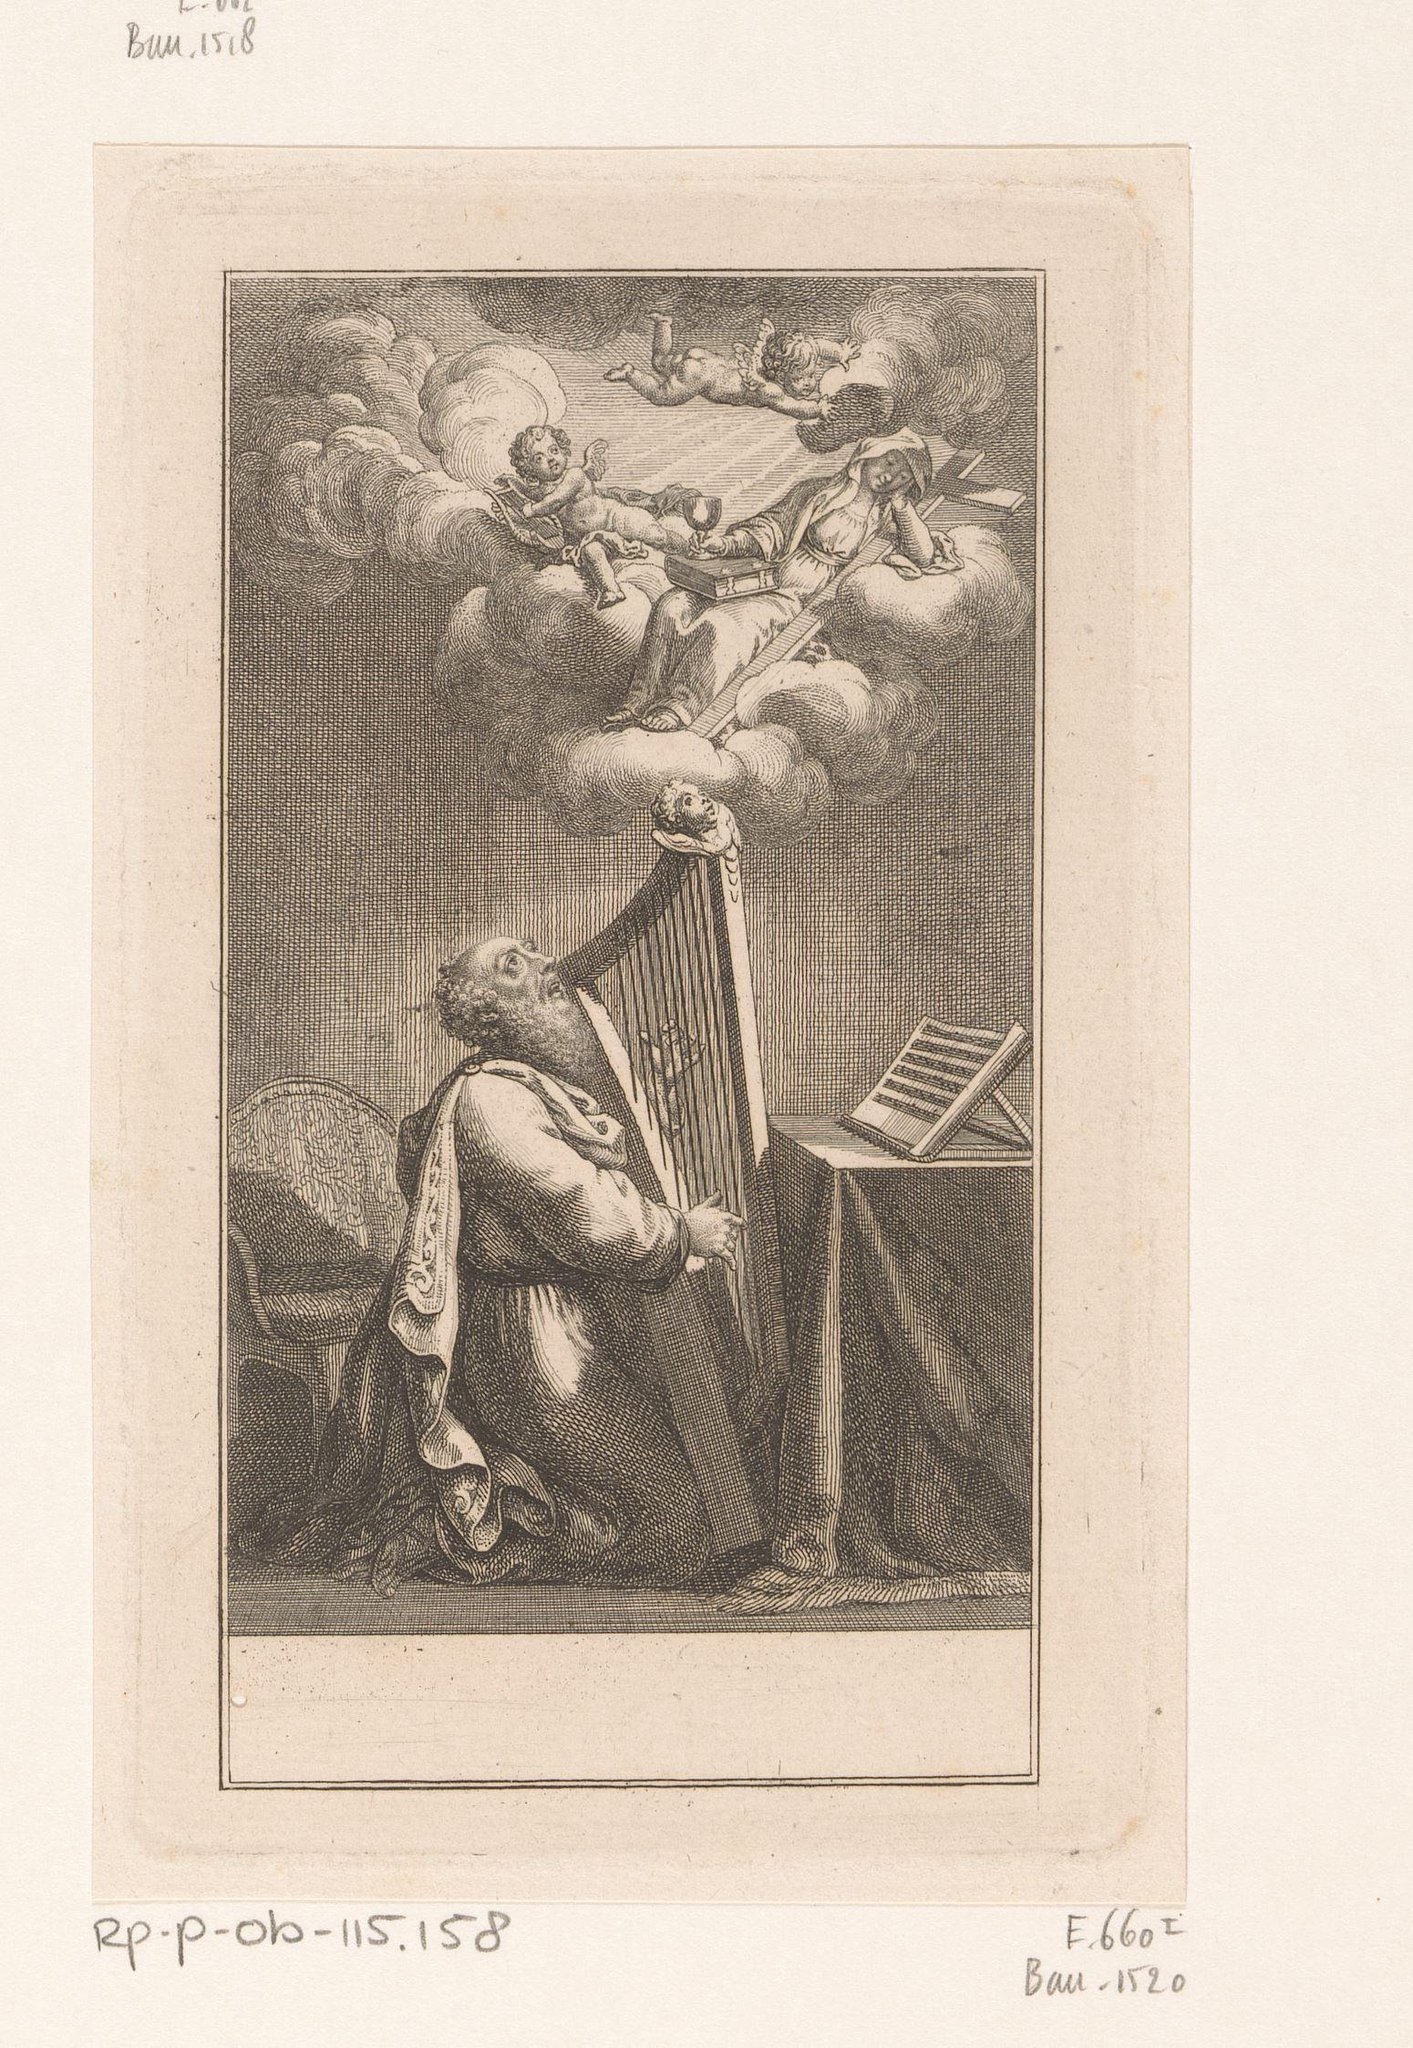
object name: print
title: Koning David speelt op de harp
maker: daniel nikolaus chodowiecki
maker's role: draughtsman, print maker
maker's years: 1726-1801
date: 1791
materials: paper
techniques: etching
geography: berlin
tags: david as musician, usually playing the harp, the church personified, 'ecclesia', usually with chalice and banner, angel(s) represented as child(ren)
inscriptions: collector's mark: Lugt 2228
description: Prent gebruikt voor: Recueil de psaumes d'Hymnes et de cantiques. Berlijn: George Fréderic Starcke, 1791.